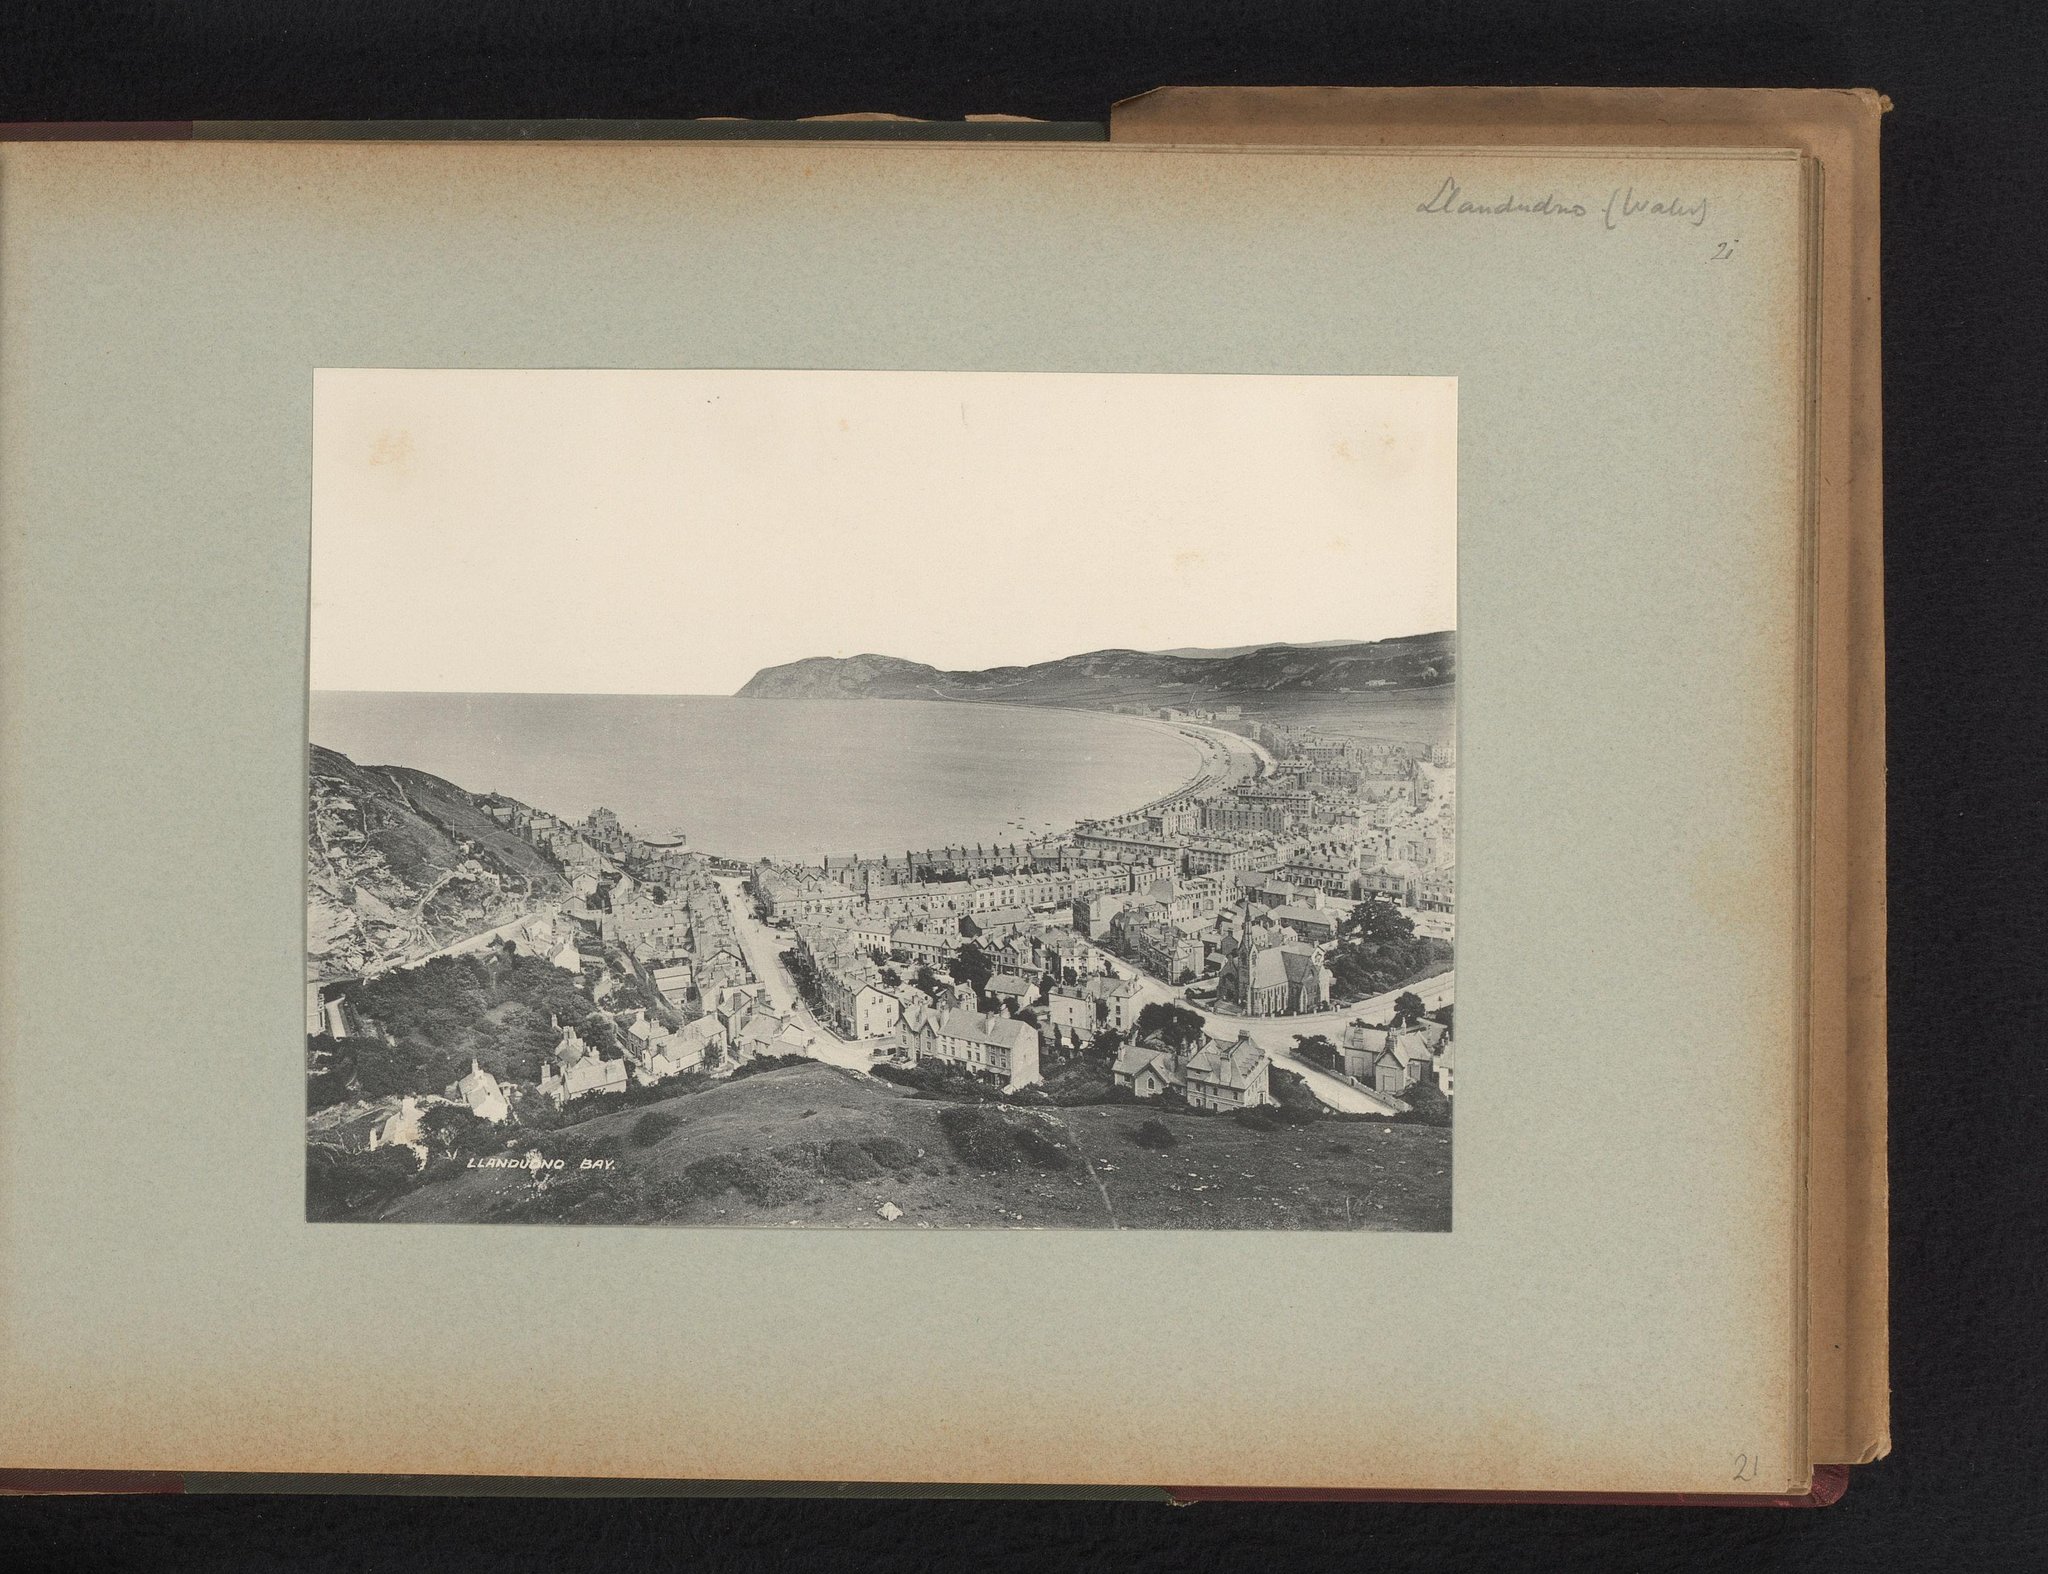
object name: photomechanical print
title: Llandudno Bay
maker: Anonymous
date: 1880-1900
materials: paper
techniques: photograph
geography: llandudno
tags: gulf, bay, city-view in general; 'veduta'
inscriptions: inscription: ‘Llanduomo (Wales)/ 21’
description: Deze prent maakt deel uit van een album.